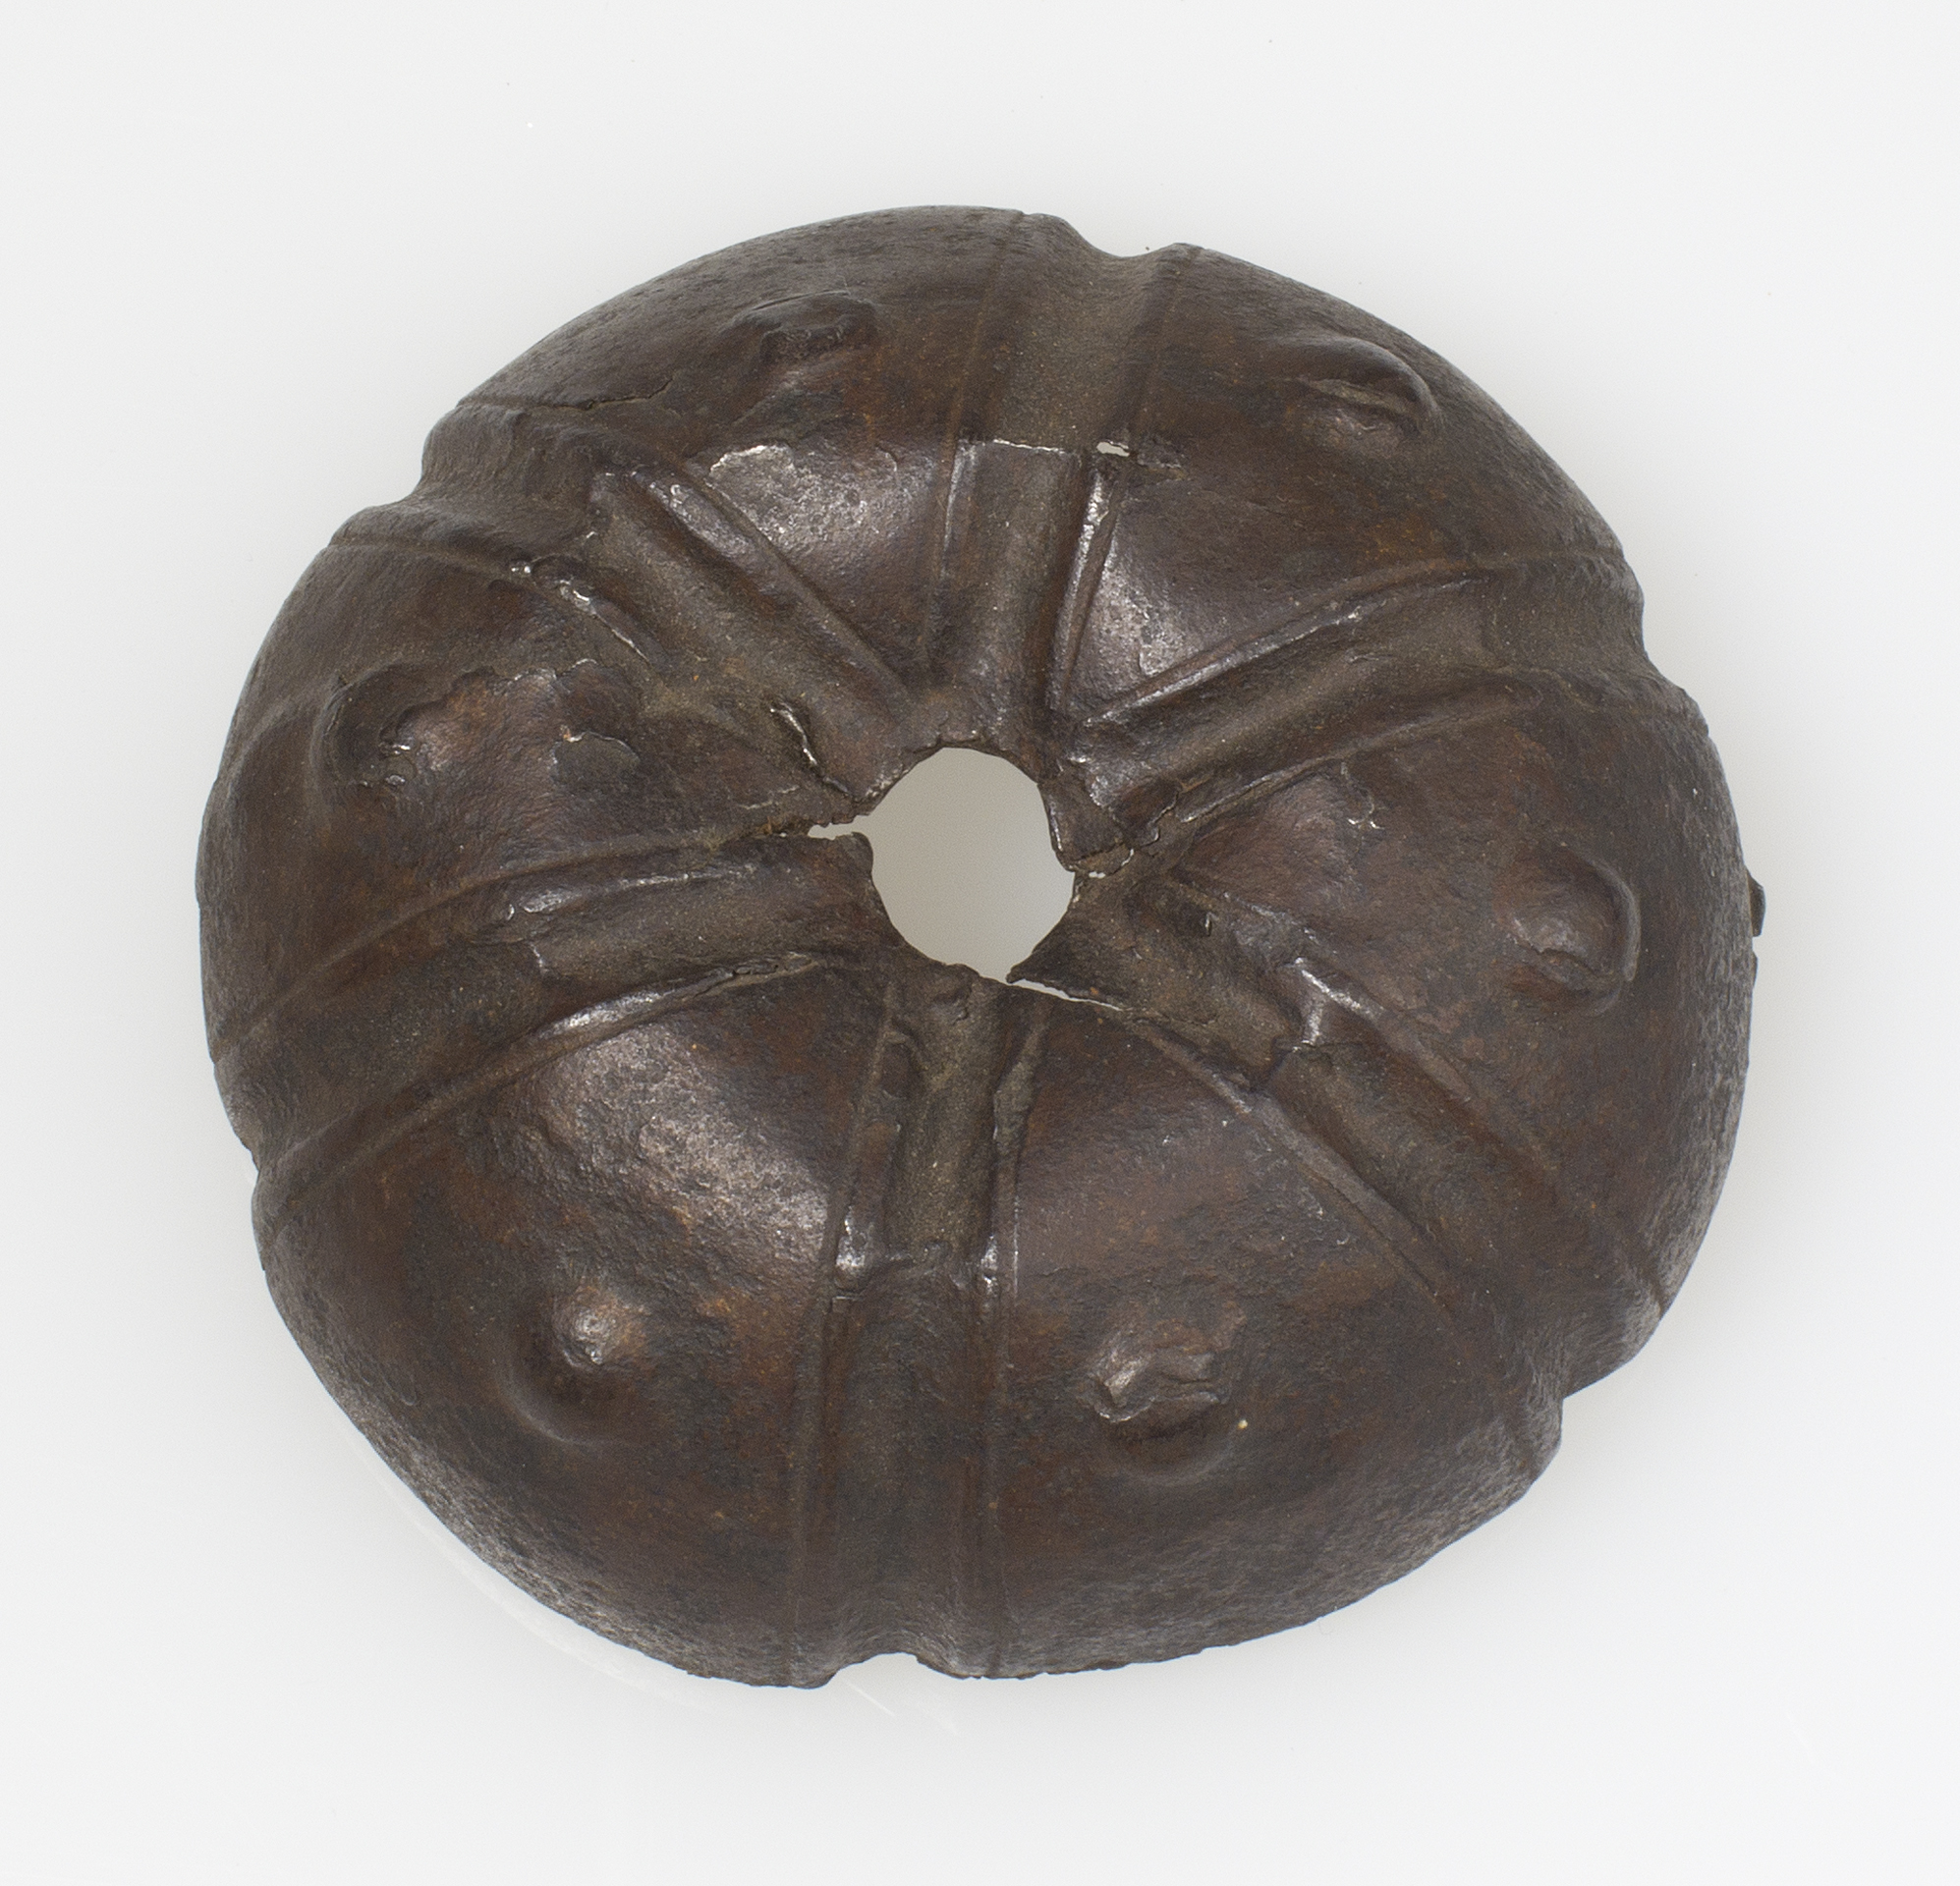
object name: bos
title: Boss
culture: european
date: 1401-1600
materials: iron